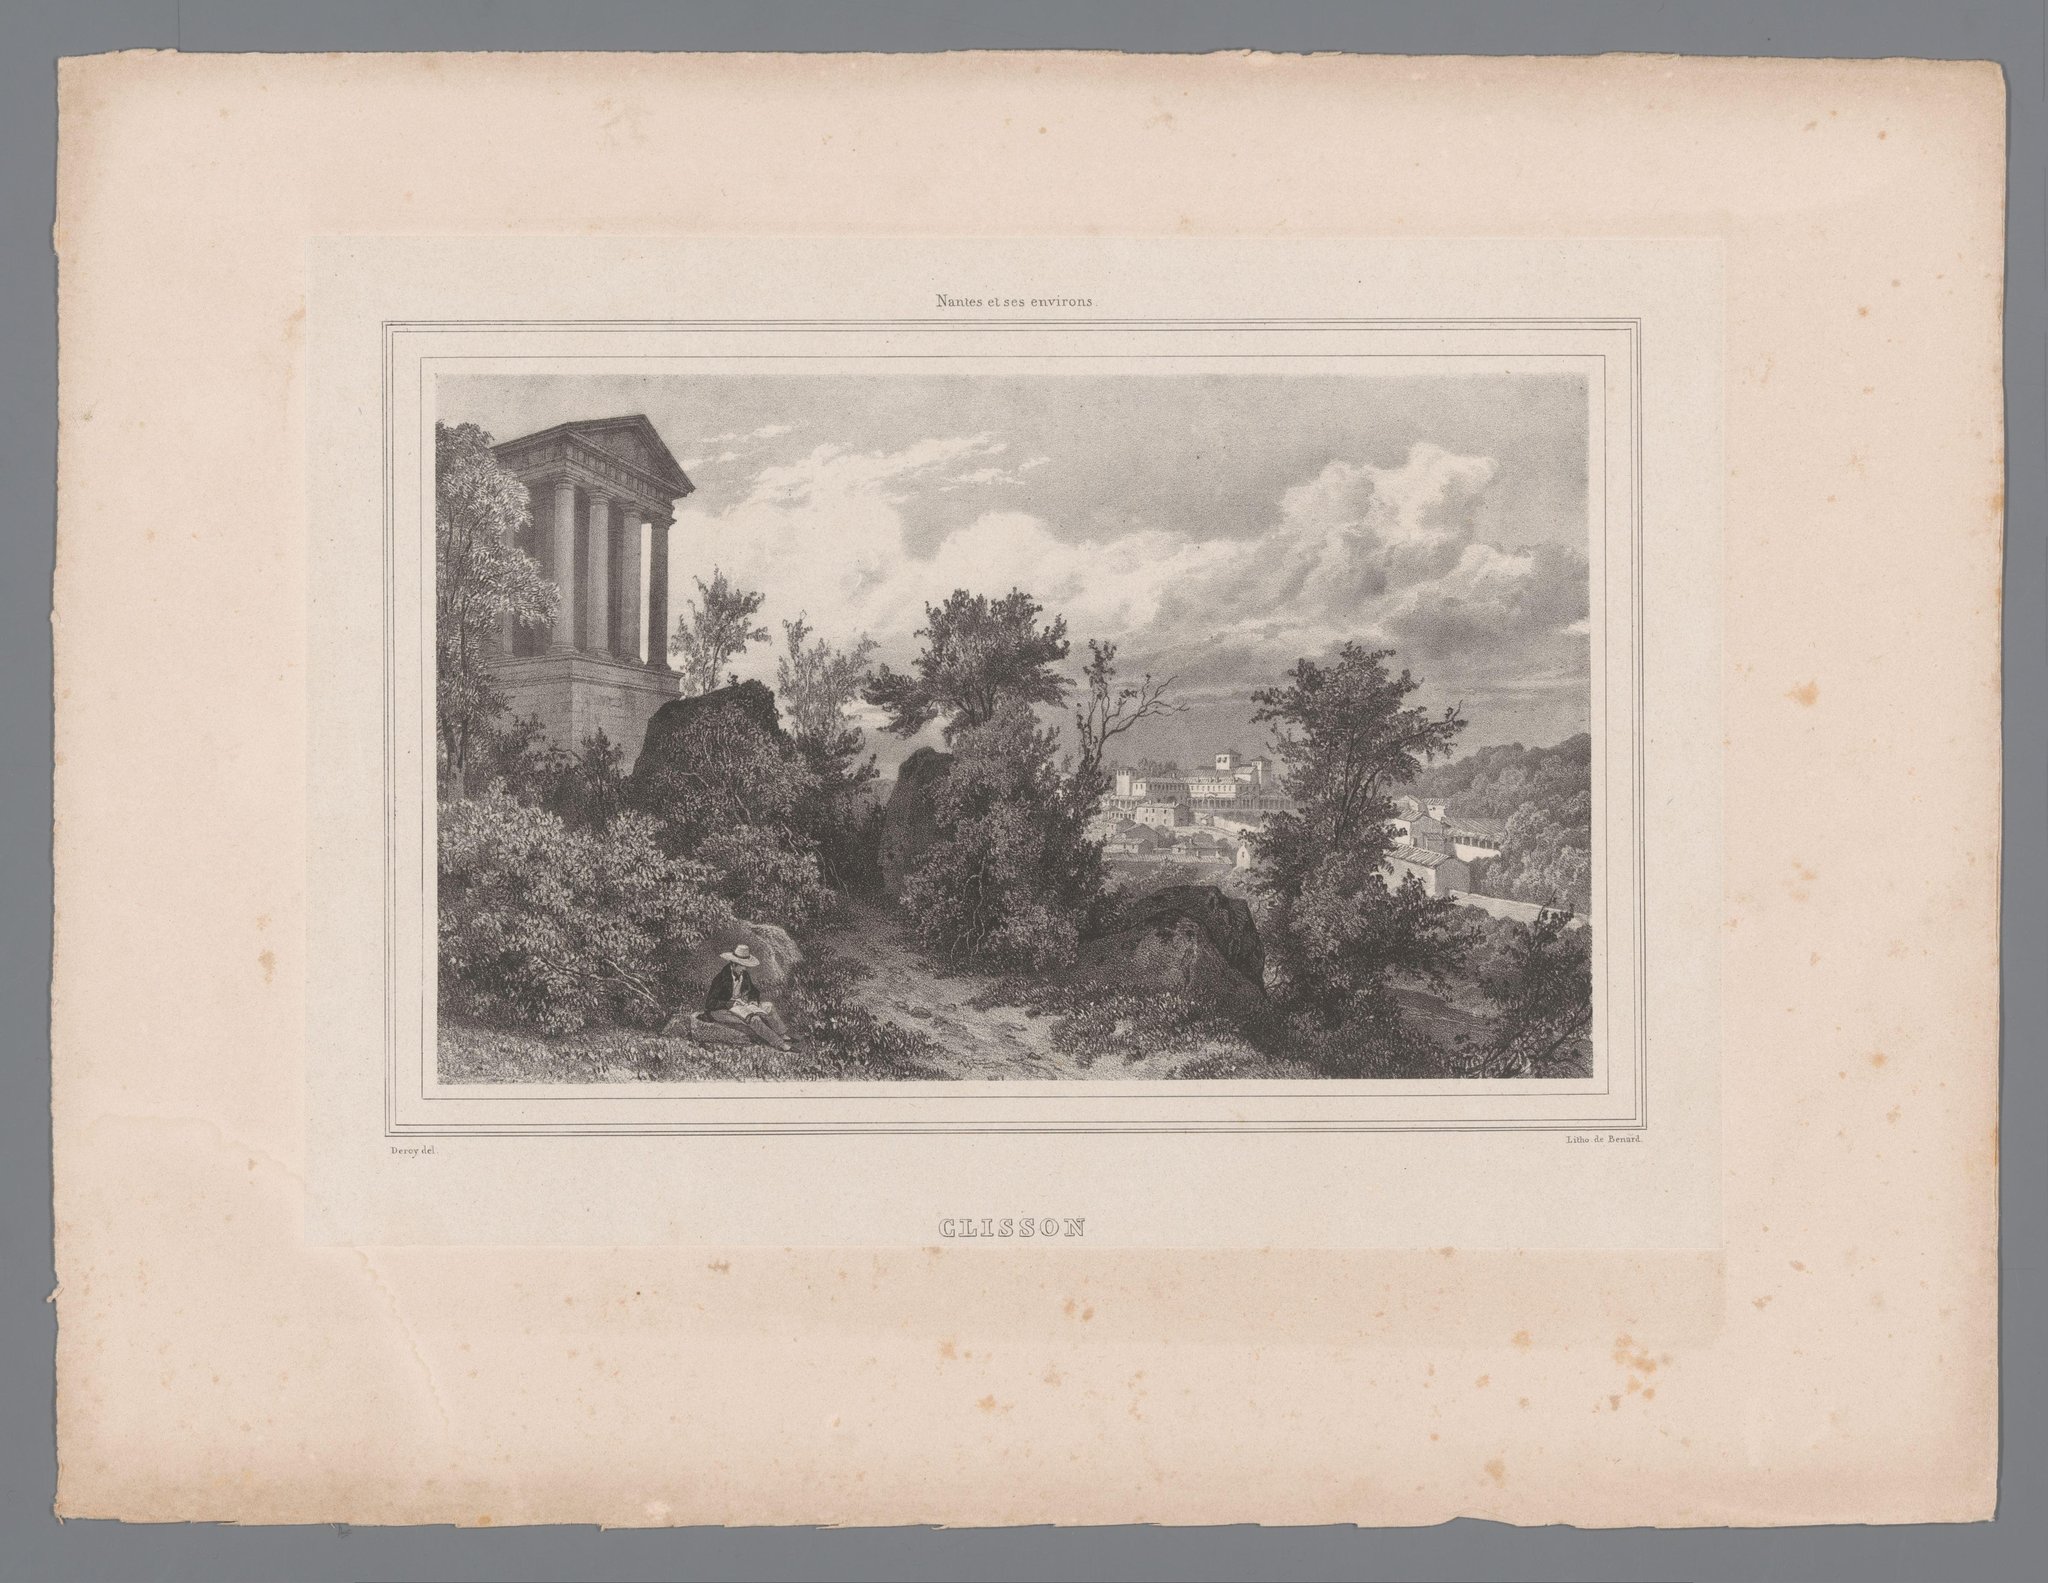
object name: print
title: Gezichten in Nantes en omgeving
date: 1833-1835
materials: paper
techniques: lithograph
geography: paris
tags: church (exterior) - qq - small church, chapel, prospect of city, town panorama, silhouette of city (+ city(-scape) with figures, staffage)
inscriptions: collector's mark: Lugt 2228a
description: Prent maakt deel uit van een omslag met achttien prenten.